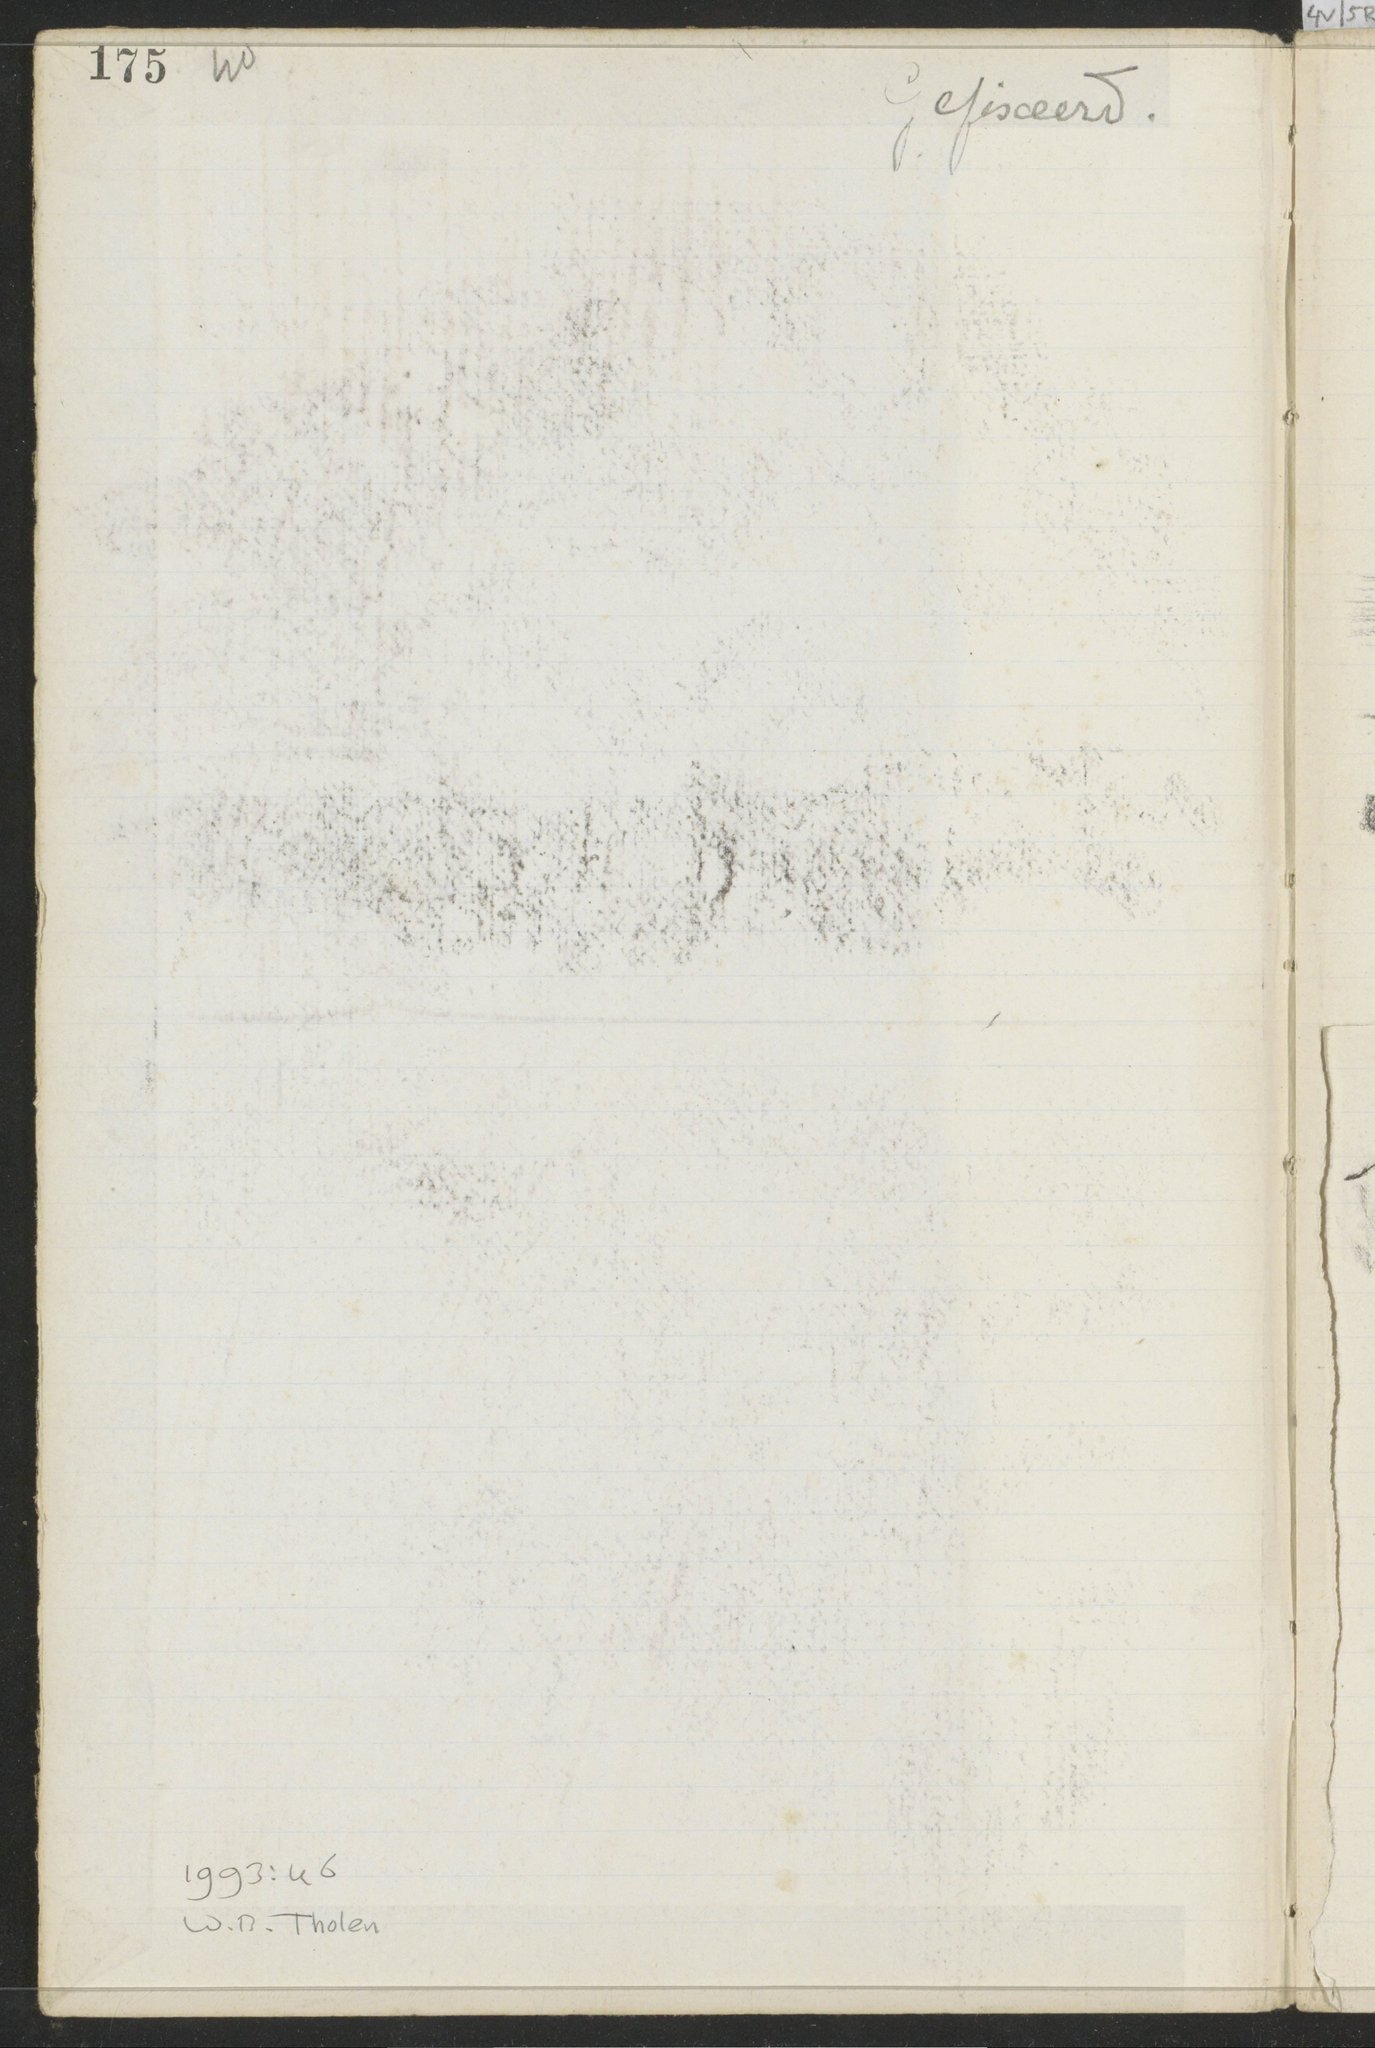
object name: sketchbook leaf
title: Notitie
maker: willem bastiaan tholen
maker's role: draughtsman, painter, print maker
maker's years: 1860-1931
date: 1900-1931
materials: pencil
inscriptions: annotation: ‘W Gefisceerd.’, number: ‘175’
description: Voorste schutblad uit een schetsboek met 55 bladen.